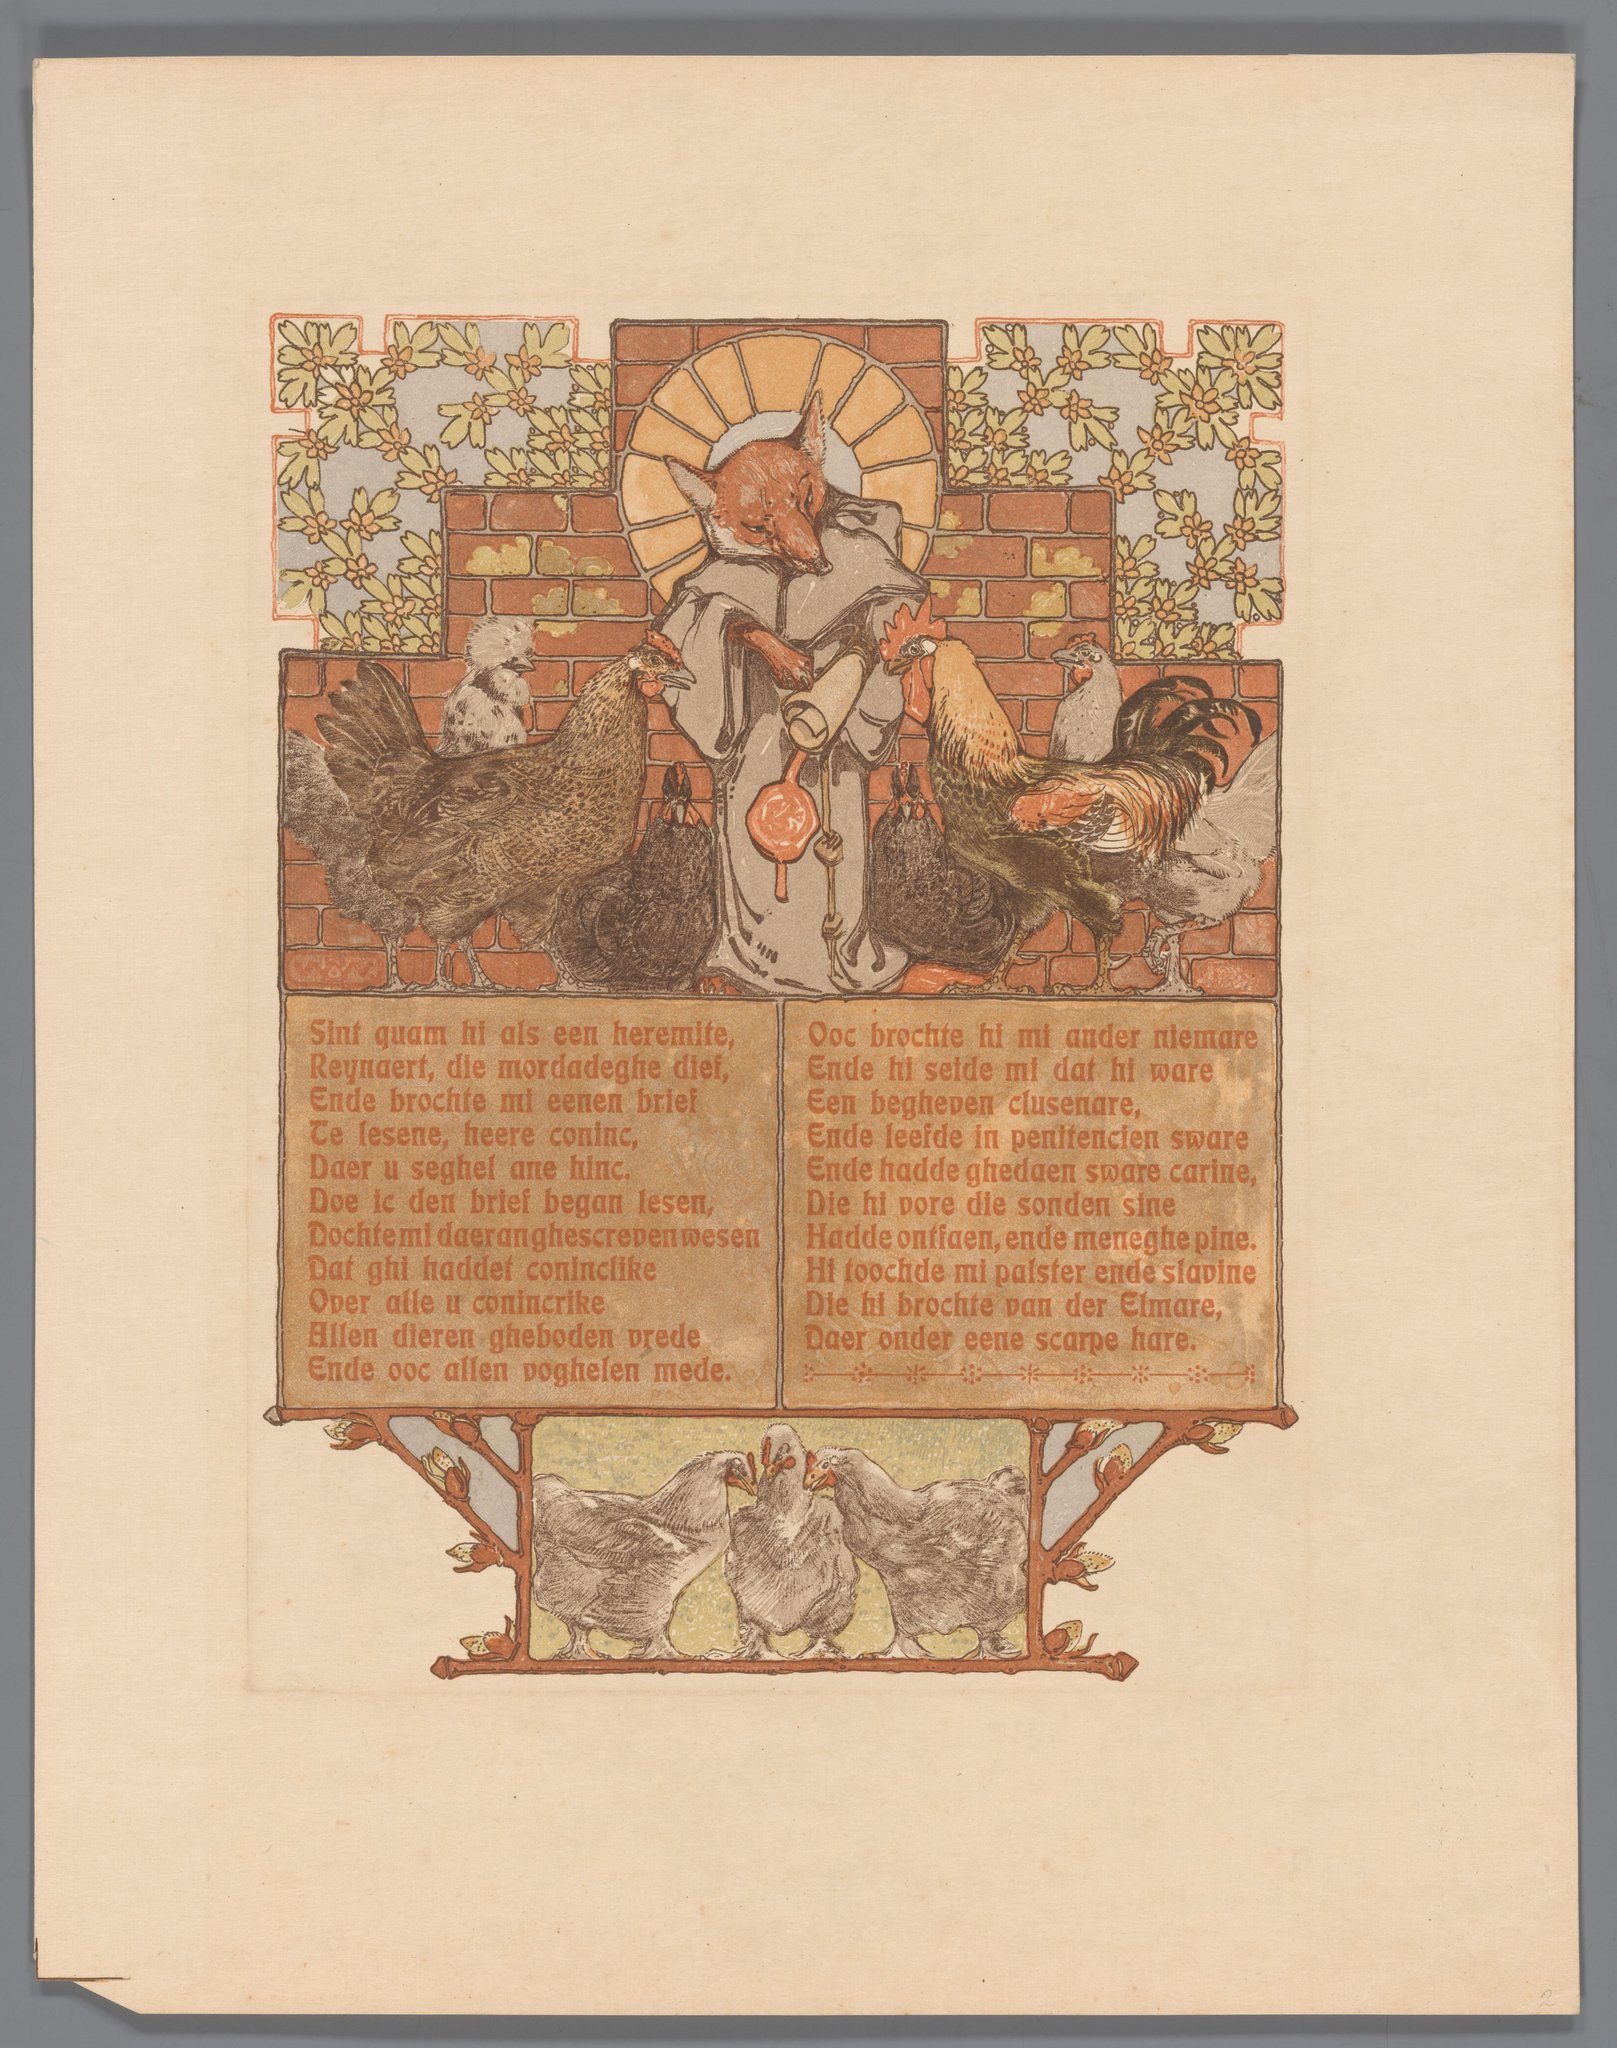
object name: book illustration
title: Vos in monnikspij (Reinaert) omringd door kippen en haan (Cantecleer)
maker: bernard willem wierink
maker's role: draughtsman, print maker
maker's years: 1856-1939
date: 1910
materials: paper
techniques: lithograph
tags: fable of reynard the fox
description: Prent gebruikt in: Streuvels, Stijn (Frank Lateur). Reinaert de Vos naar verschillende uitgaven van het middeleeuwsche epos. Amsterdam: L.J. Veen, 1910.